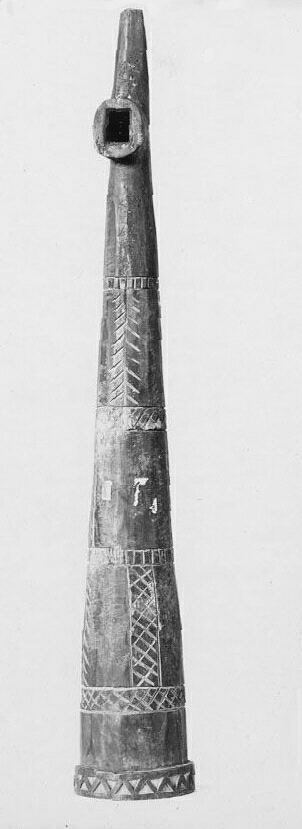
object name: horn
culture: mayumba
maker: mayumba people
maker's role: maker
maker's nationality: congo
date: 1867-1900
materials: wood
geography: congo